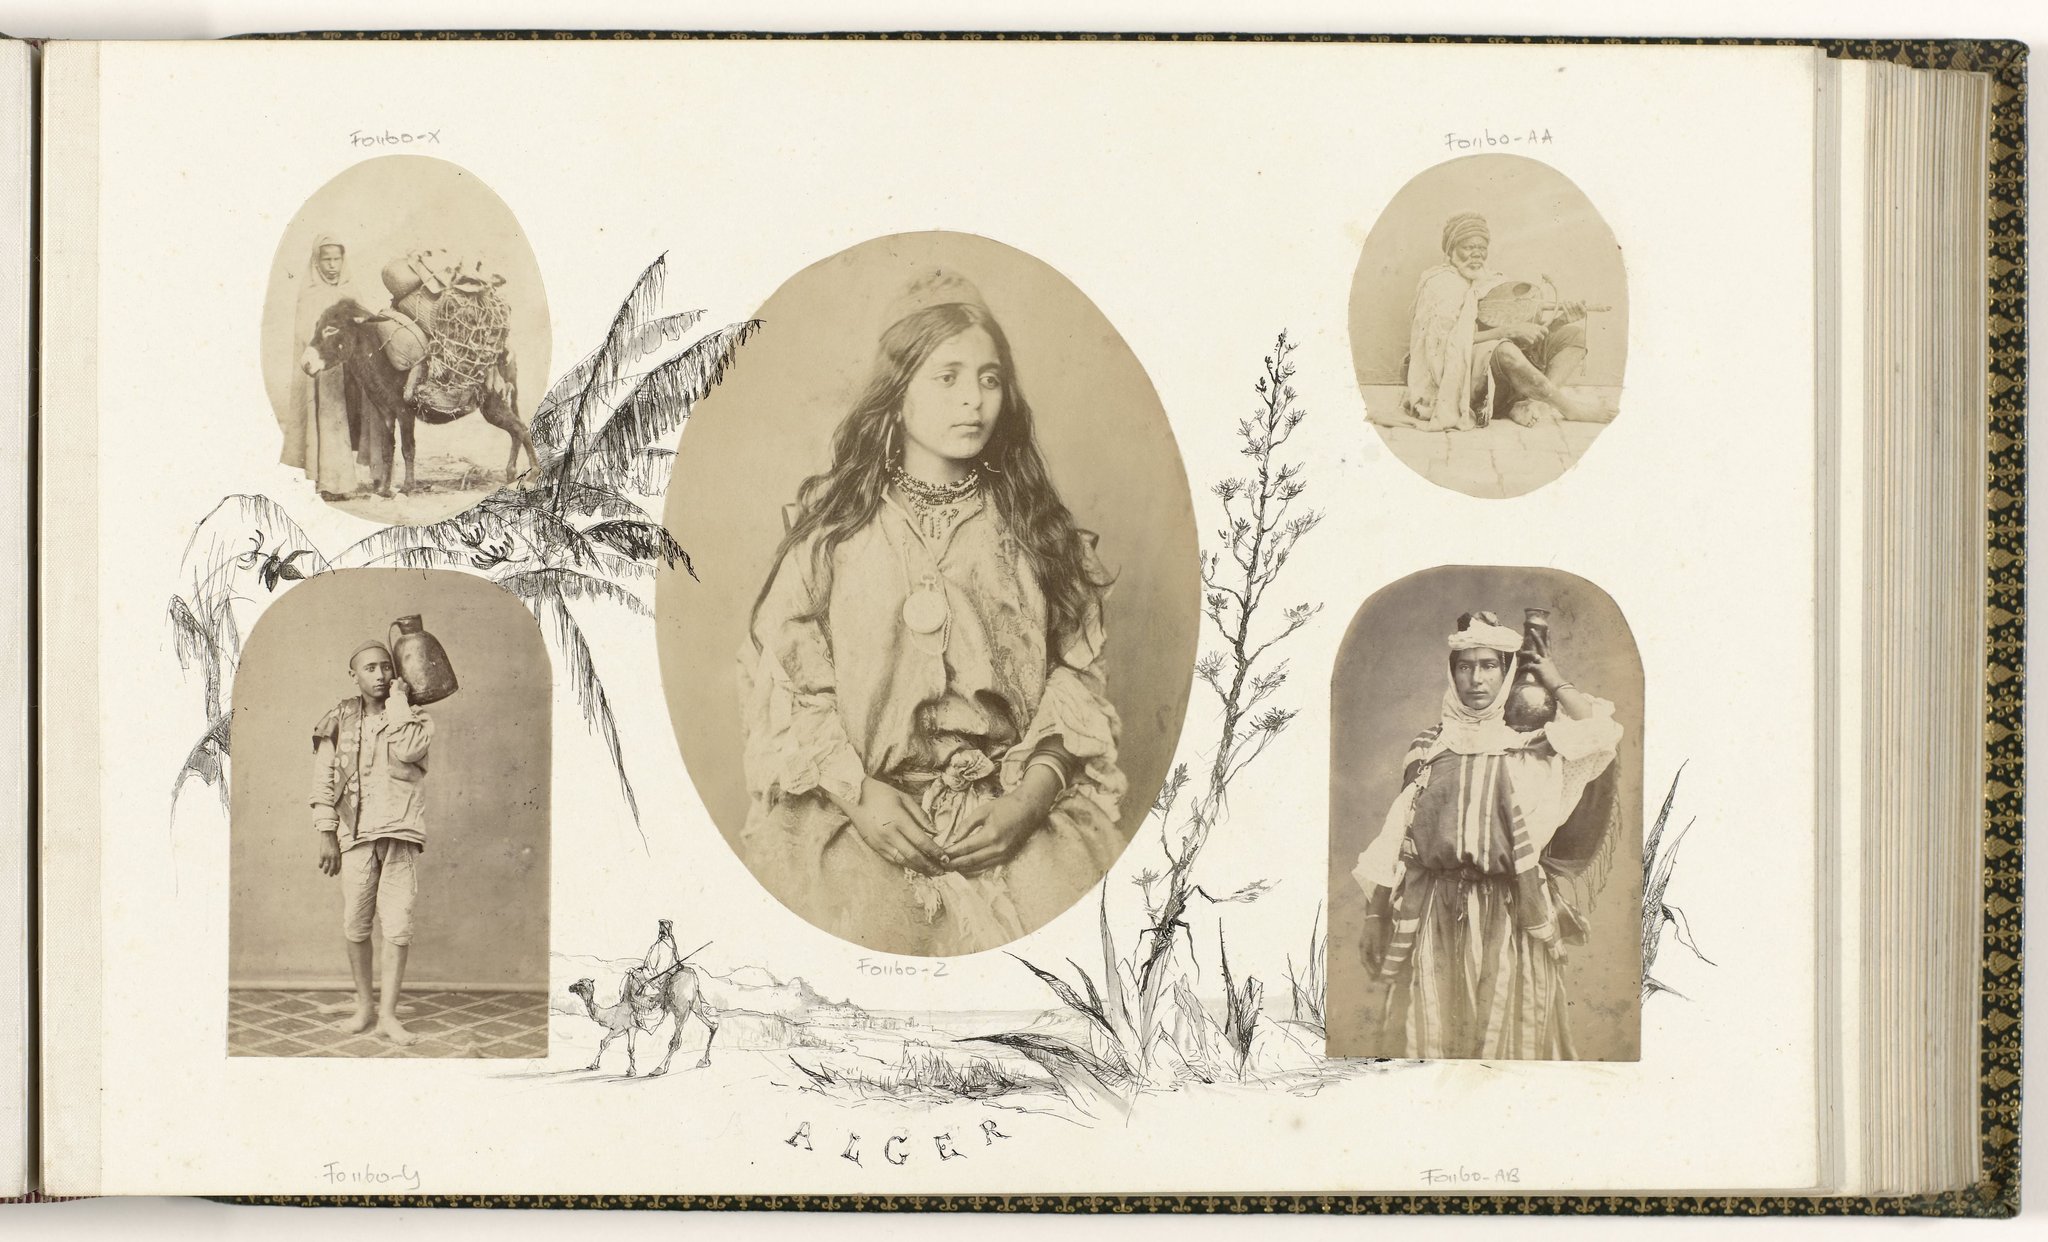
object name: photograph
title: Portret van een onbekend meisje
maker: Anonymous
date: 1865-1875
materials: paper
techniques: albumen print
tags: historical persons, girl (child between toddler and youth)